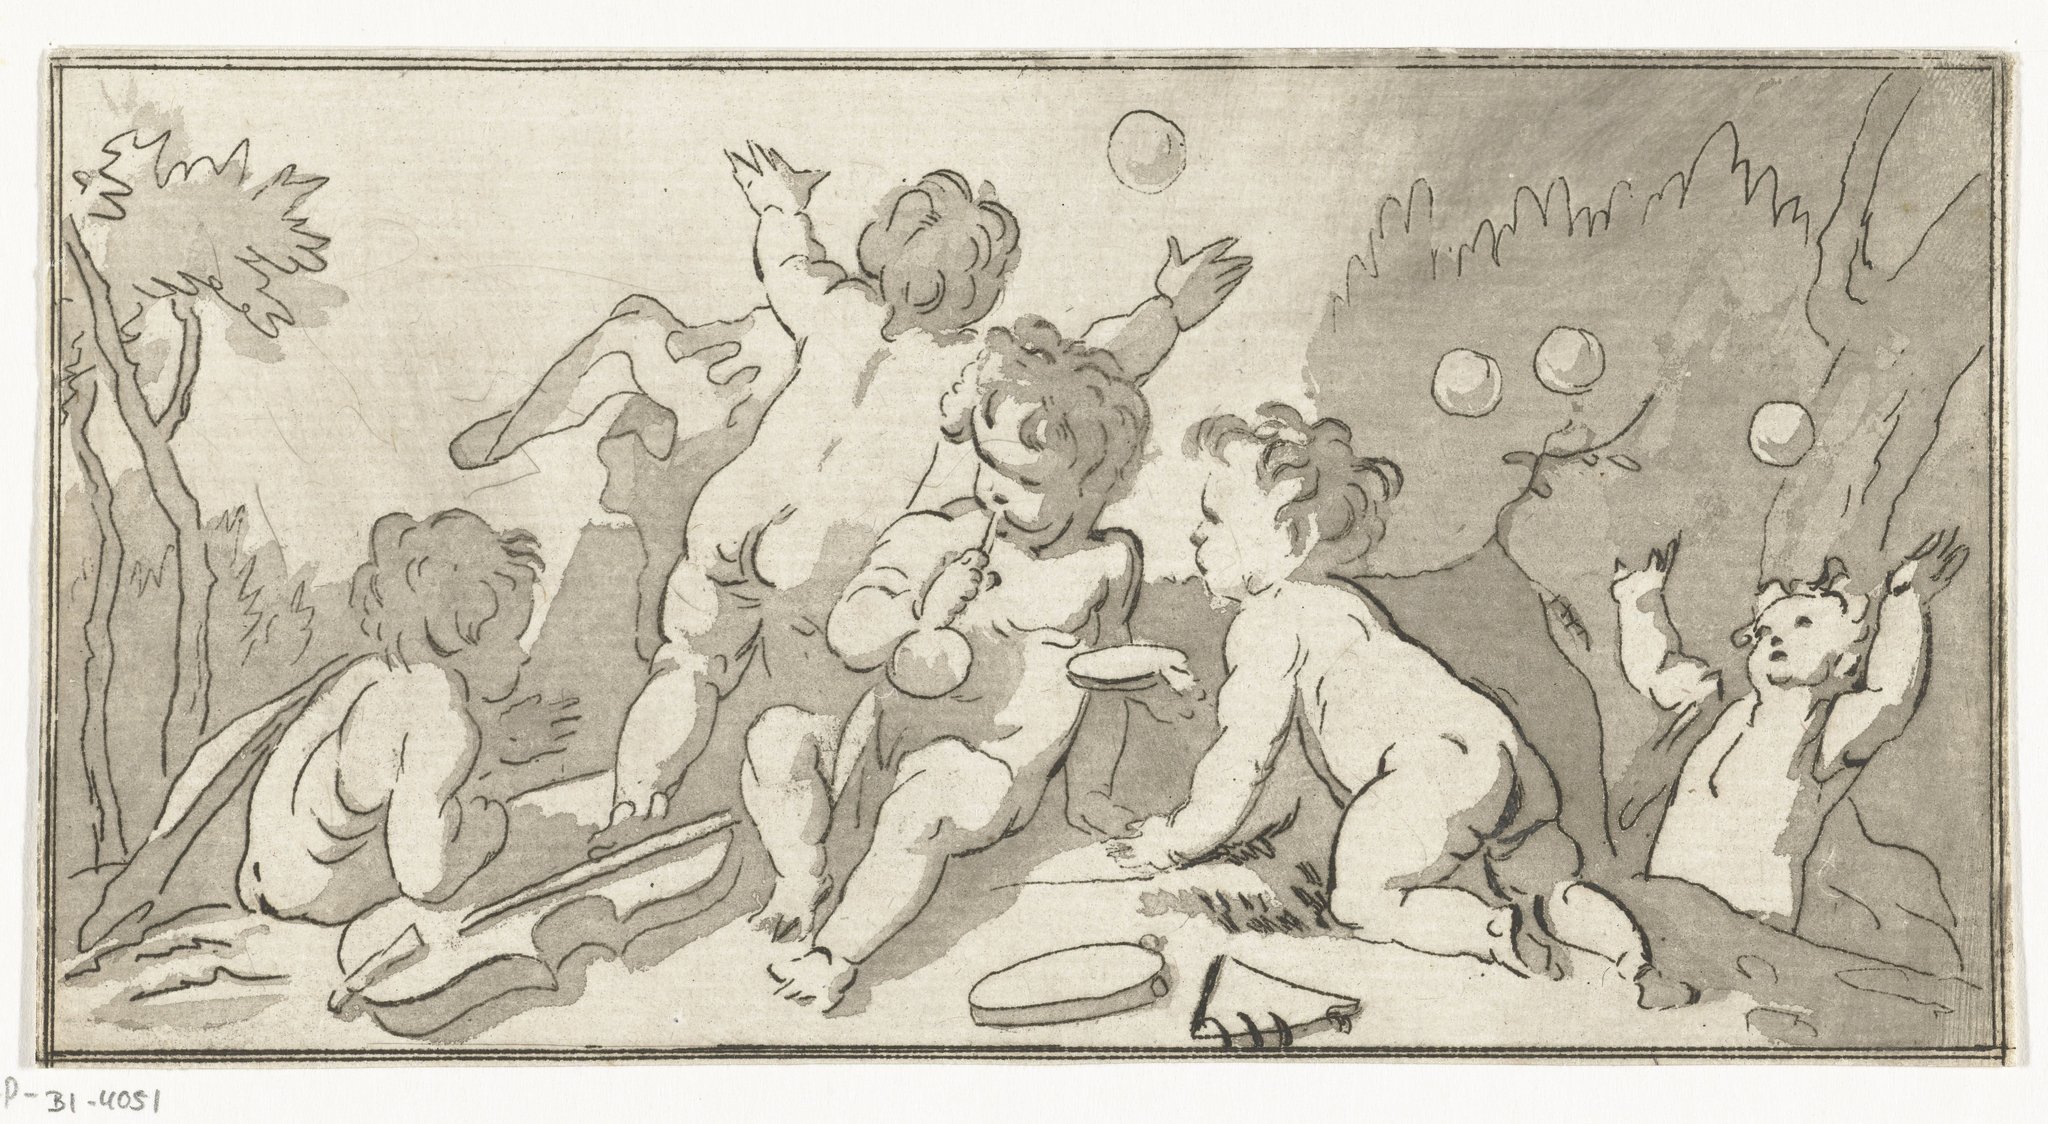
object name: print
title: Bellenblazende putti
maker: anthonie van den bos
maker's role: draughtsman, print maker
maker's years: 1763-1838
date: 1778-1838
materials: paper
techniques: aquatint, etching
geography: netherlands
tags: (children or putti) blowing bubbles, 'homo bulla' ~ scene symbolizing 'vanitas'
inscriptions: collector's mark: Lugt 2228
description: Vijf putti zitten op een heuvel. Een van hen blaast bellen, de anderen proberen de bellen te vangen.